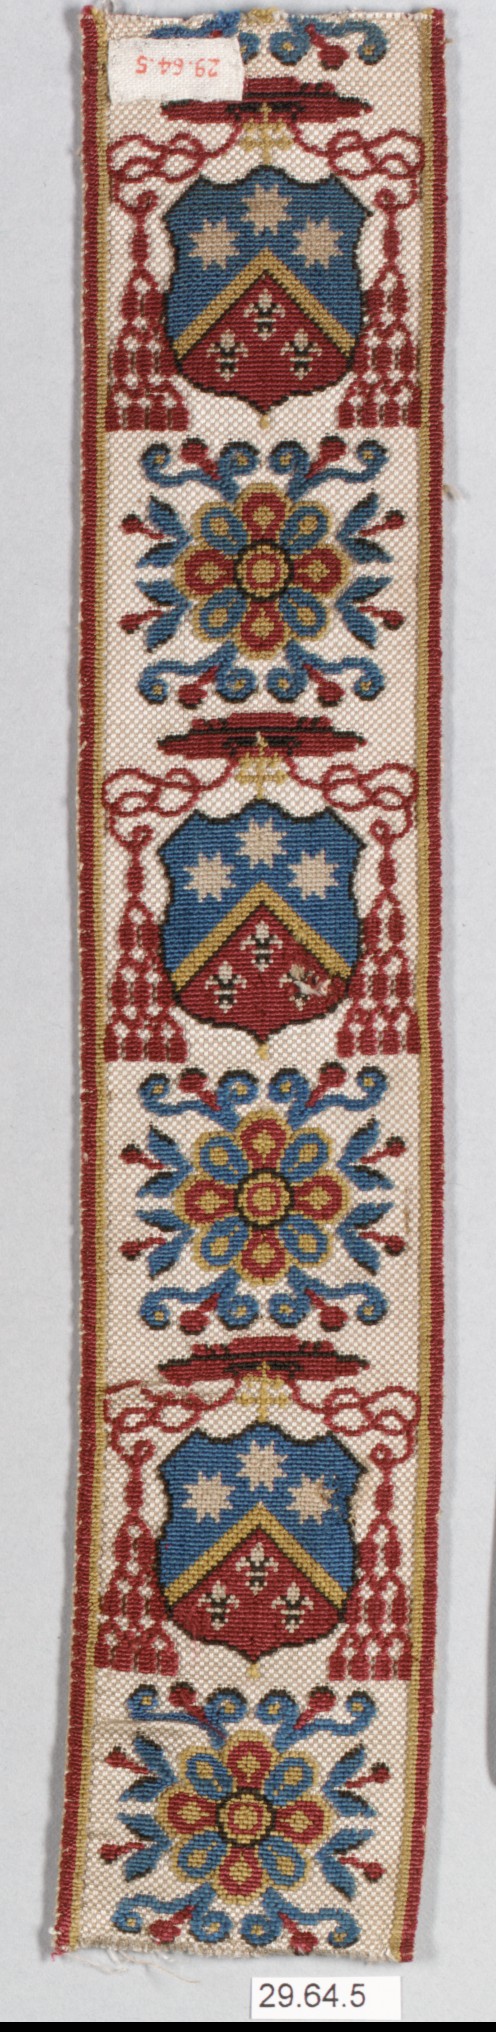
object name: galloon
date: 1701-1900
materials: silk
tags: coat of arms